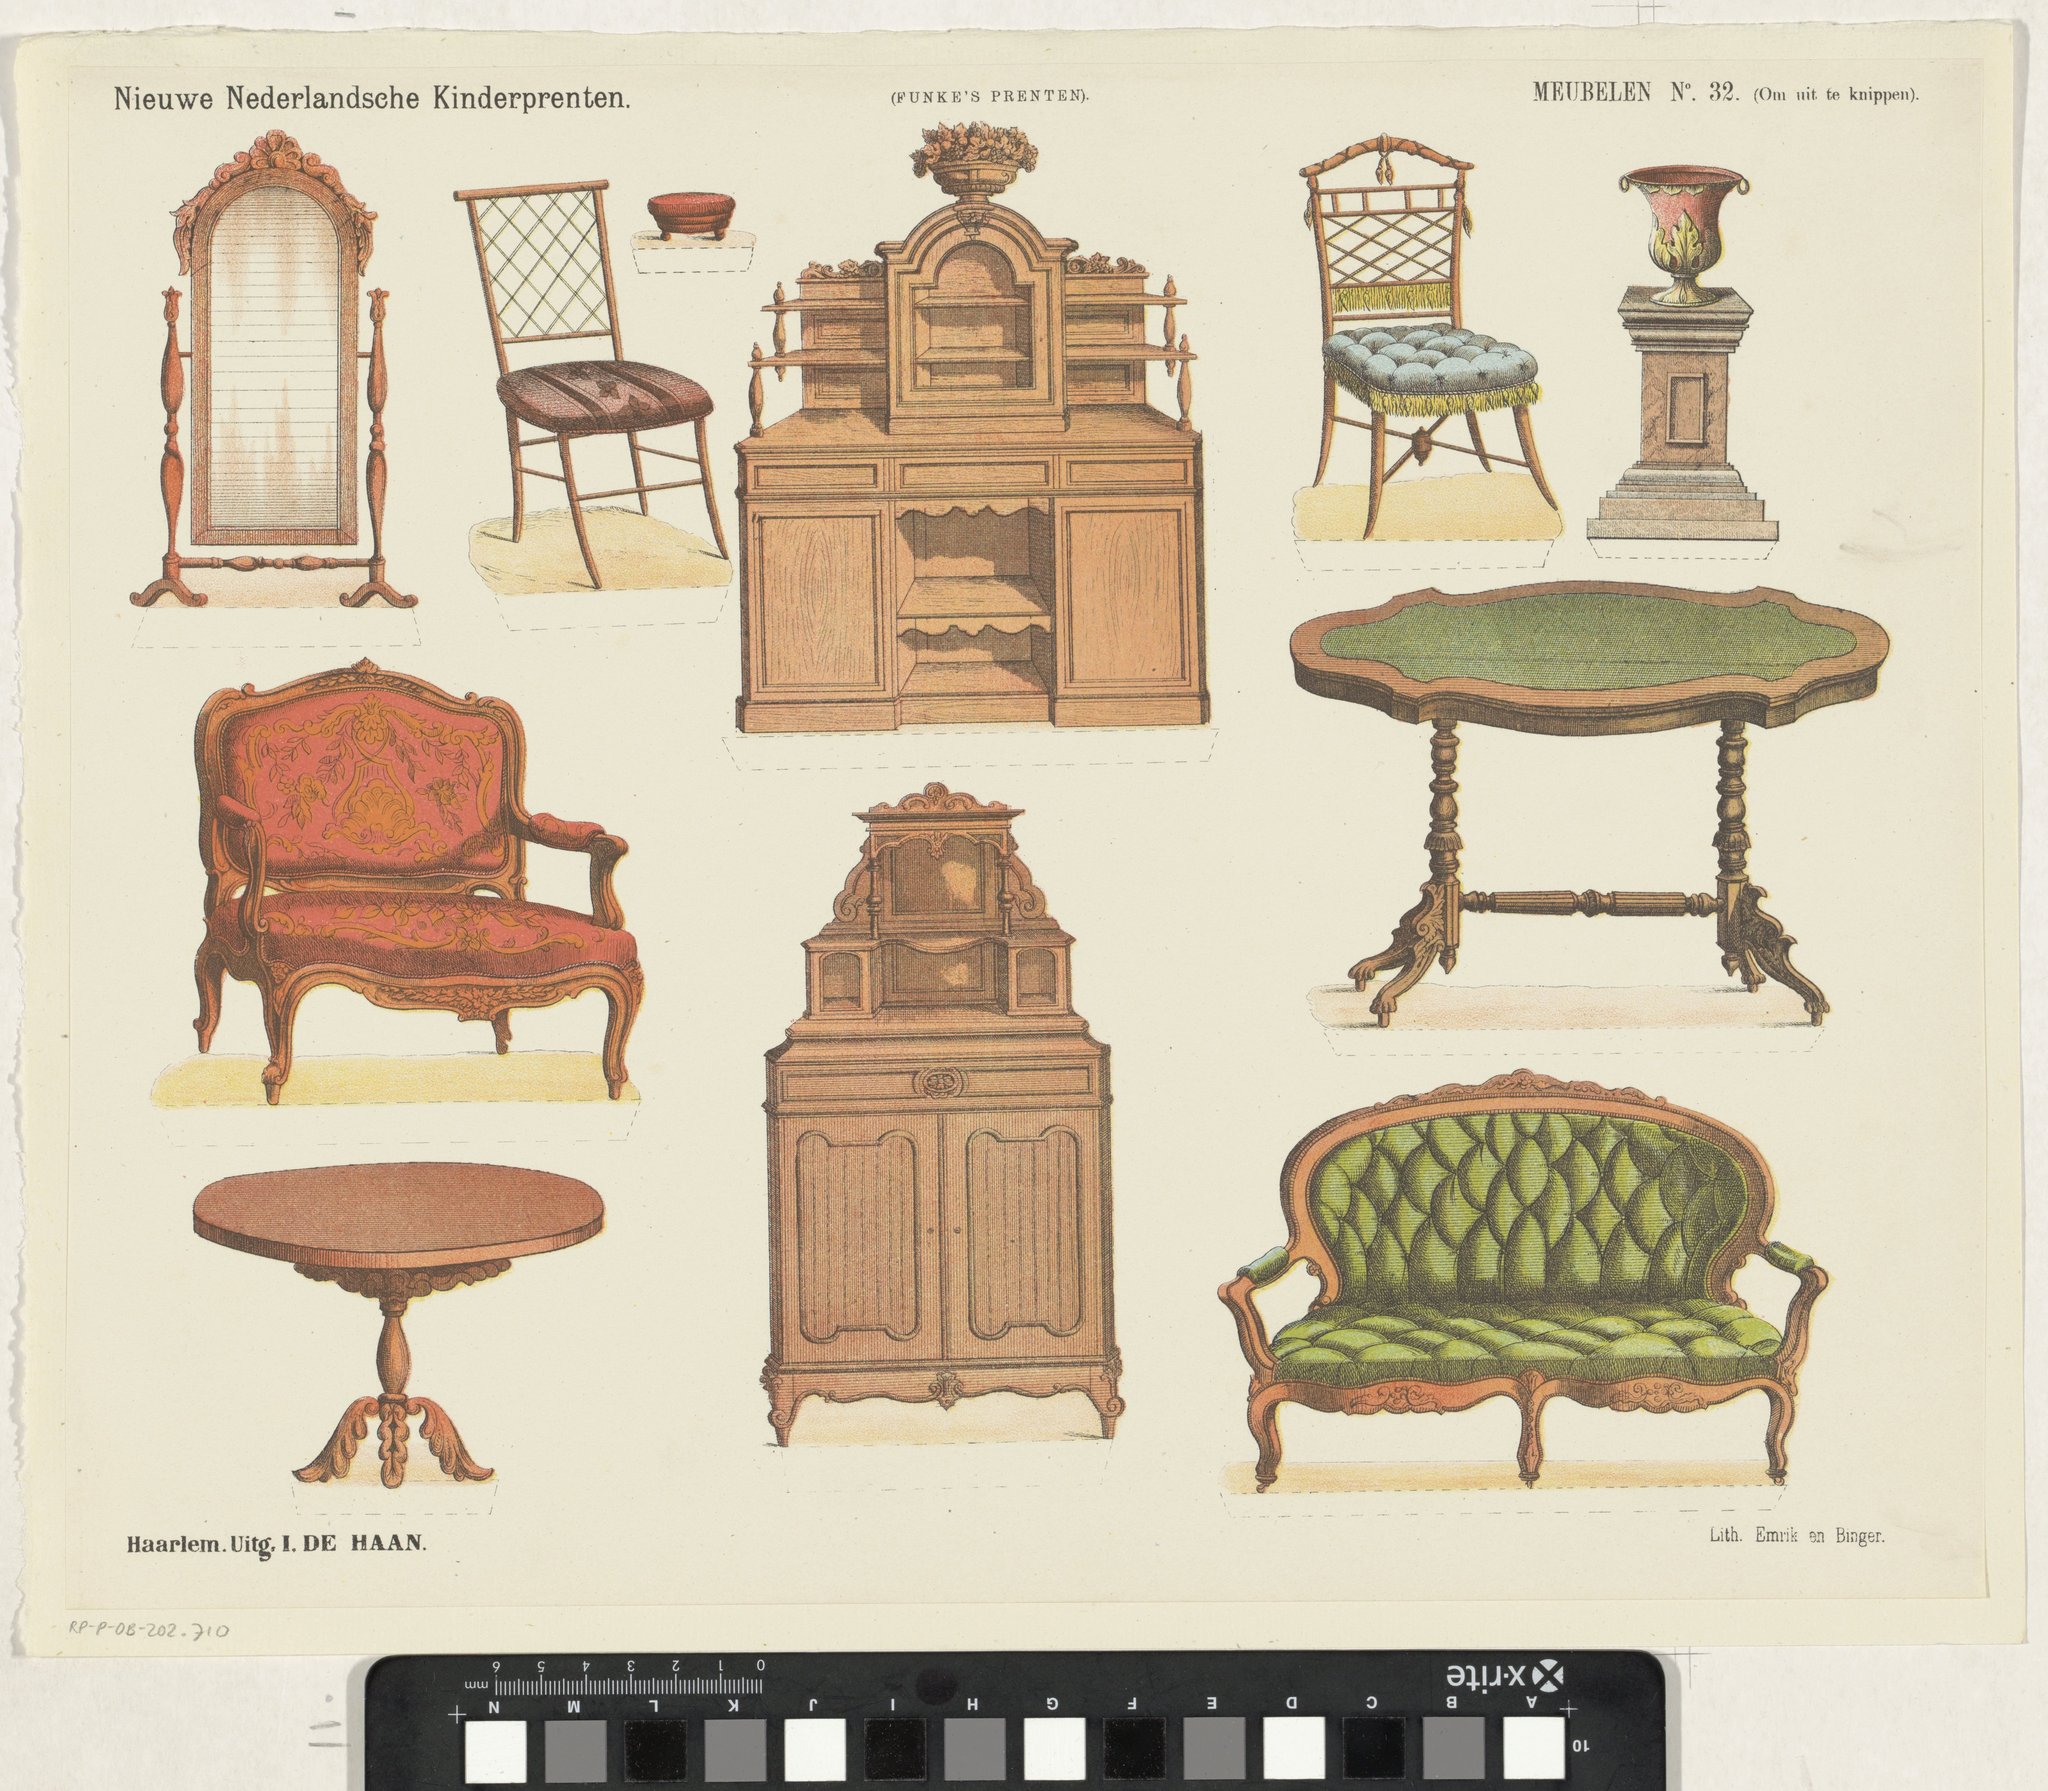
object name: print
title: Funke's prenten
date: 1875-1903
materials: paper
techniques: lithograph, letterpress printing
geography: haarlem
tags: seating furniture, mirror, table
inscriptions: collector's mark: Lugt 2760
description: Blad met 11 voorstellingen van meubelstukken om uit te knippen, waaronder stoelen, kasten en tafels. Genummerd rechtsboven: No. 32.